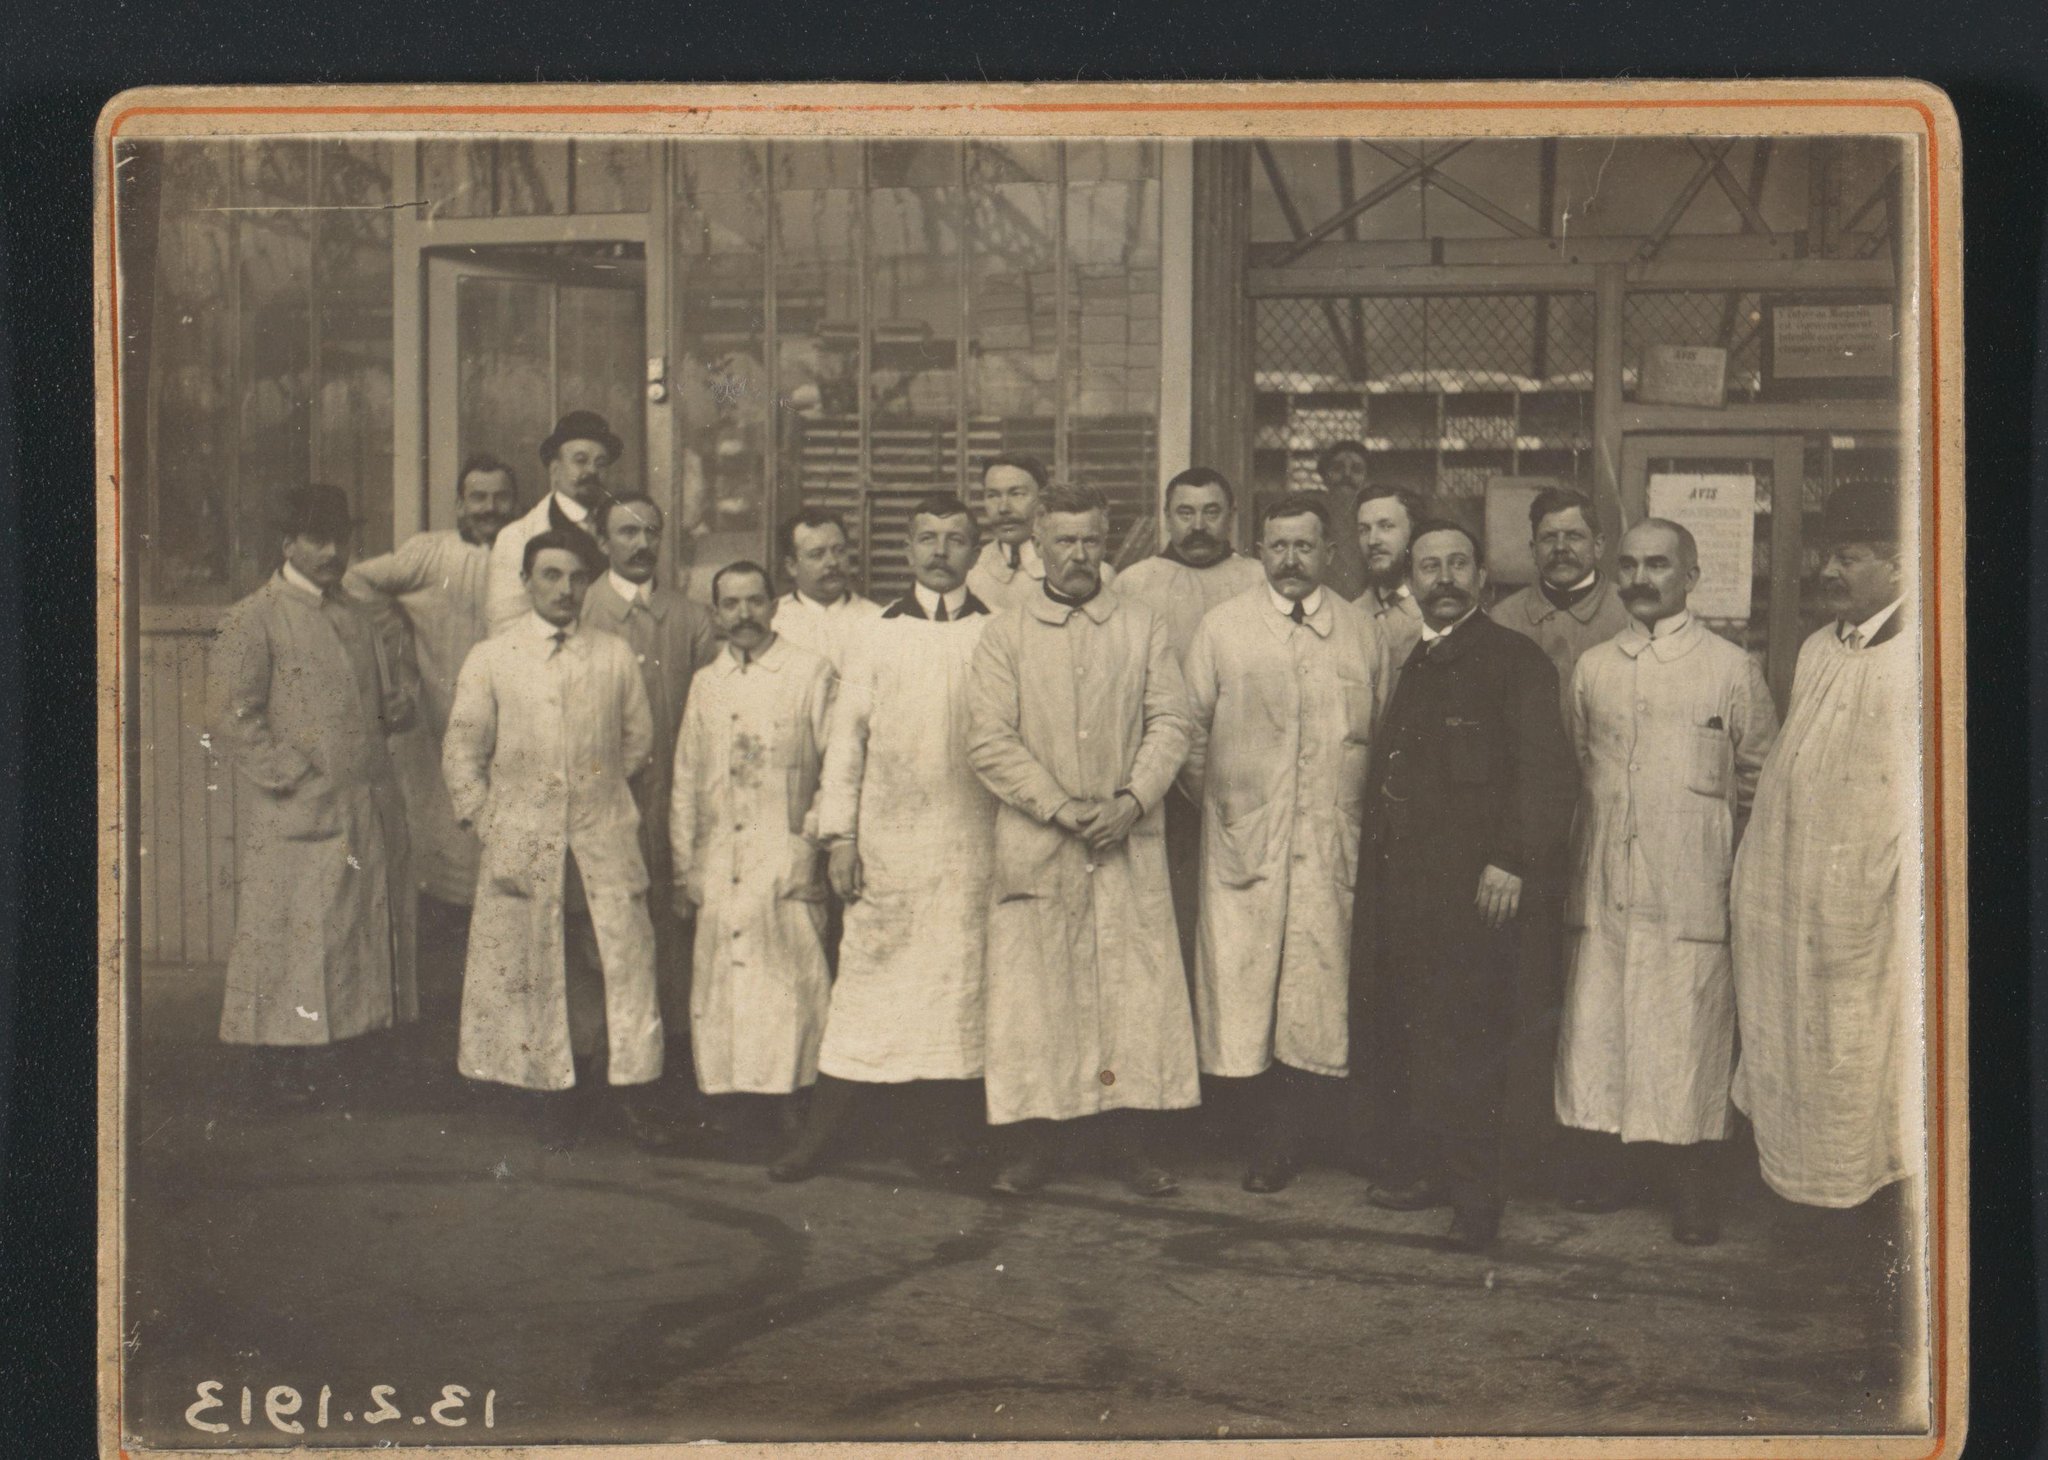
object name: photograph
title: Werknemers van Renault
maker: Anonymous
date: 1913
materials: cardboard, photographic support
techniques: gelatin silver print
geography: france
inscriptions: annotation: ‘usine Renault’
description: Groep mannen, op één na allemaal in witte stofjas, poserend buiten fabriek.